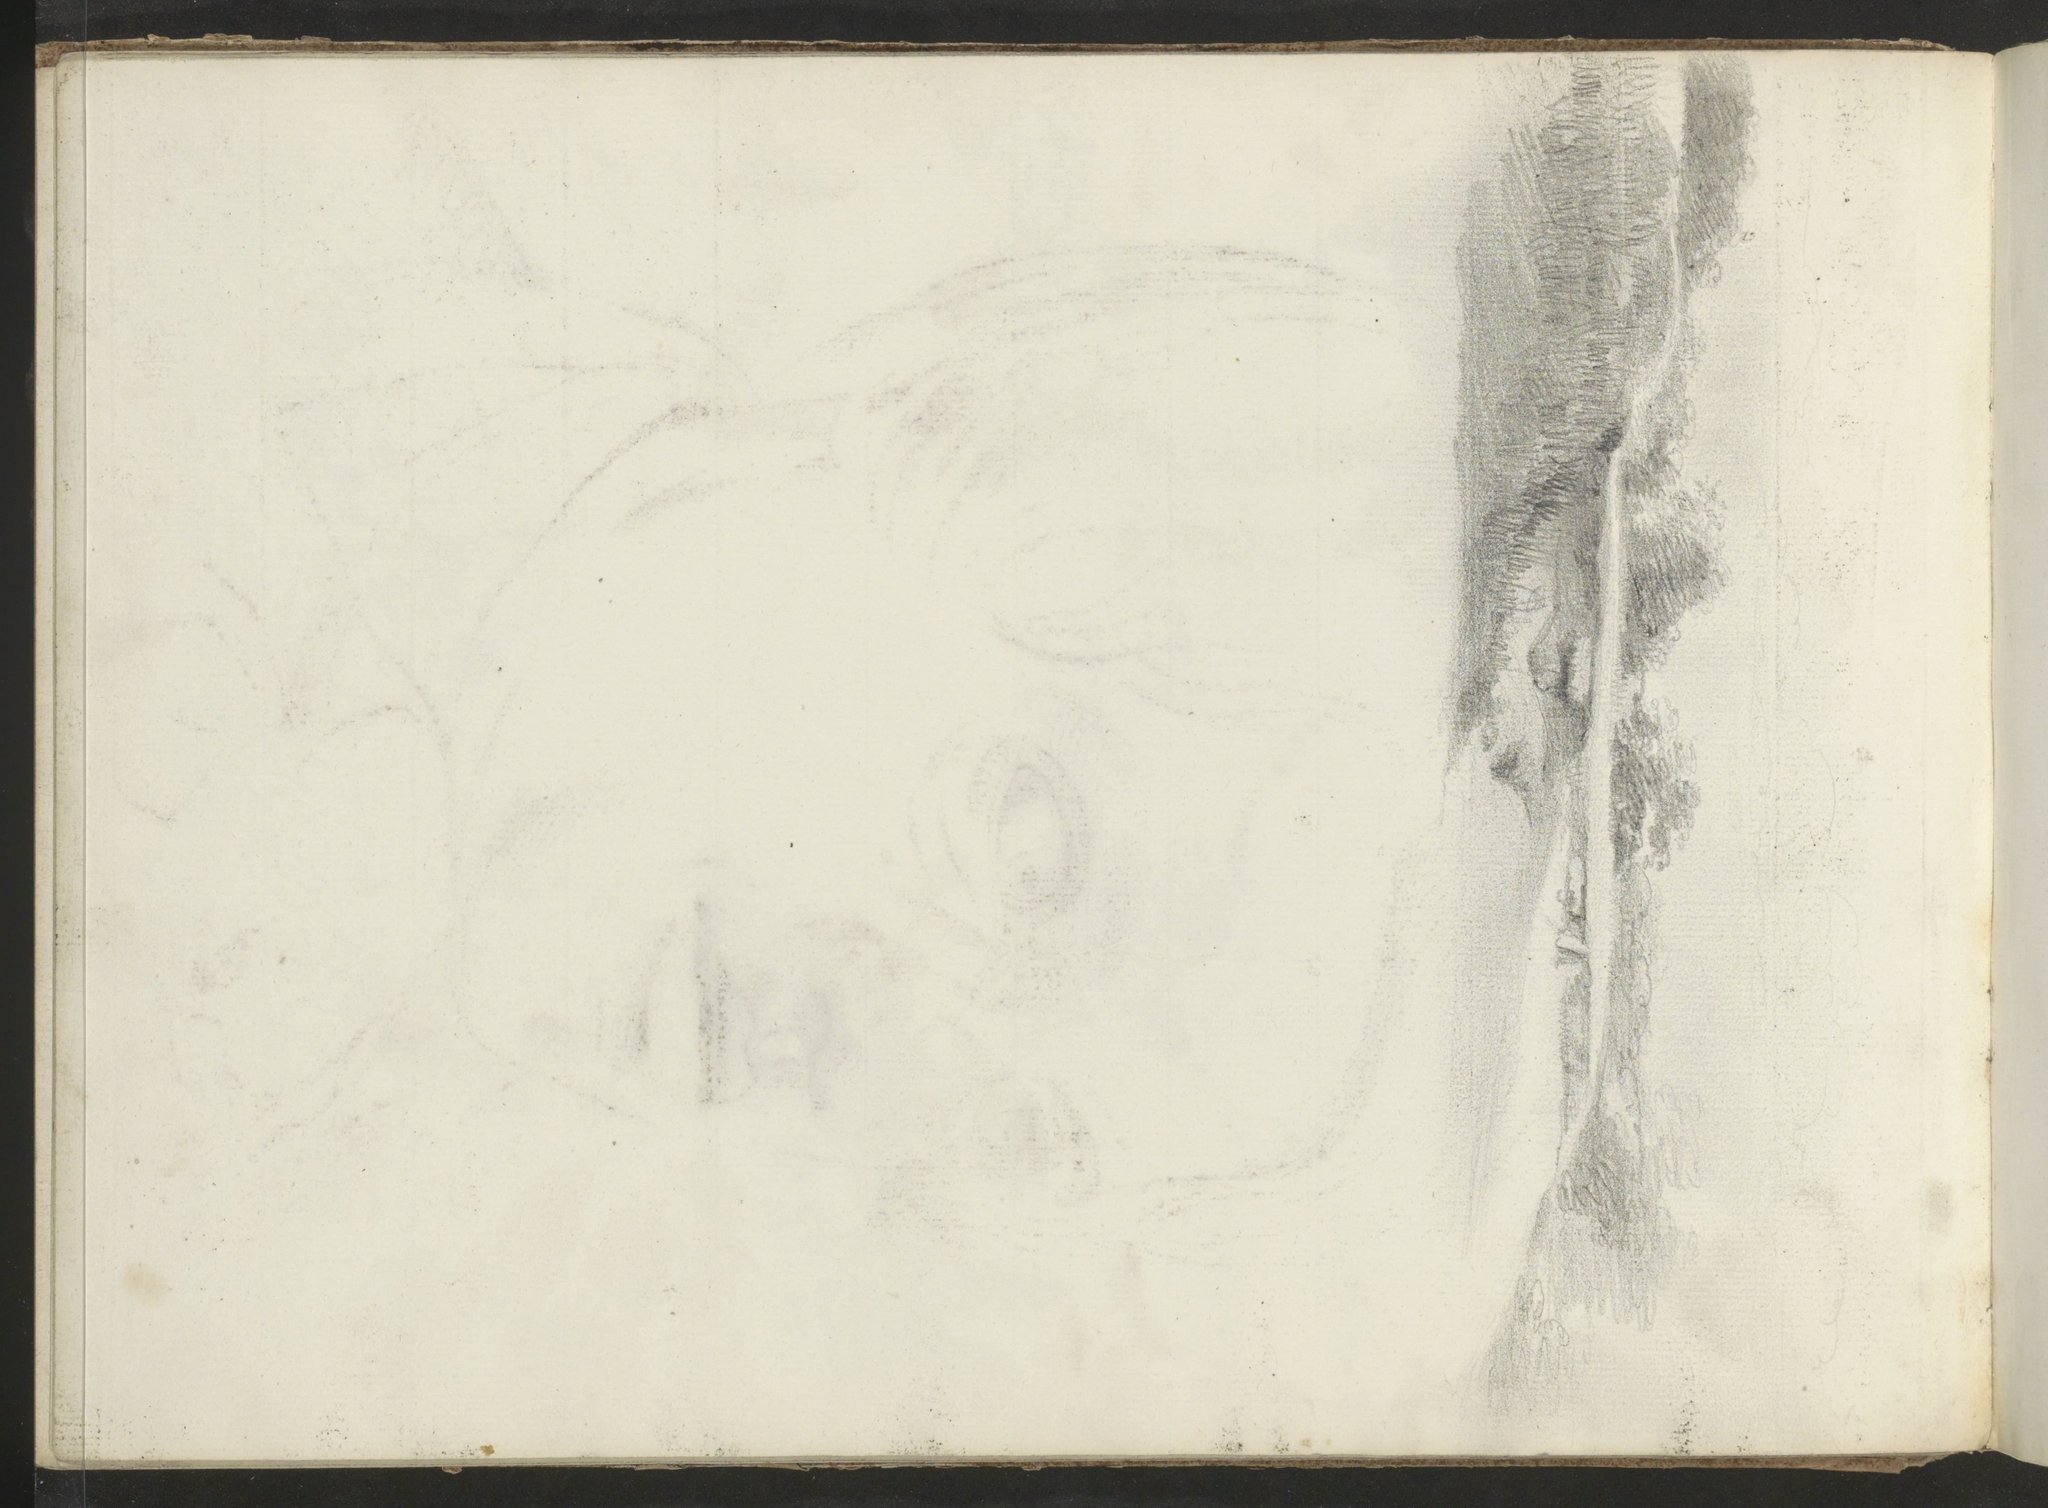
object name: sketchbook leaf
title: Landschap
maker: s. altmann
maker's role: painter, print maker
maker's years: 1822-1890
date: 1803-1840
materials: paper, pencil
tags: landscapes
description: Blad 9 verso uit een schetsboek met 24 bladen.